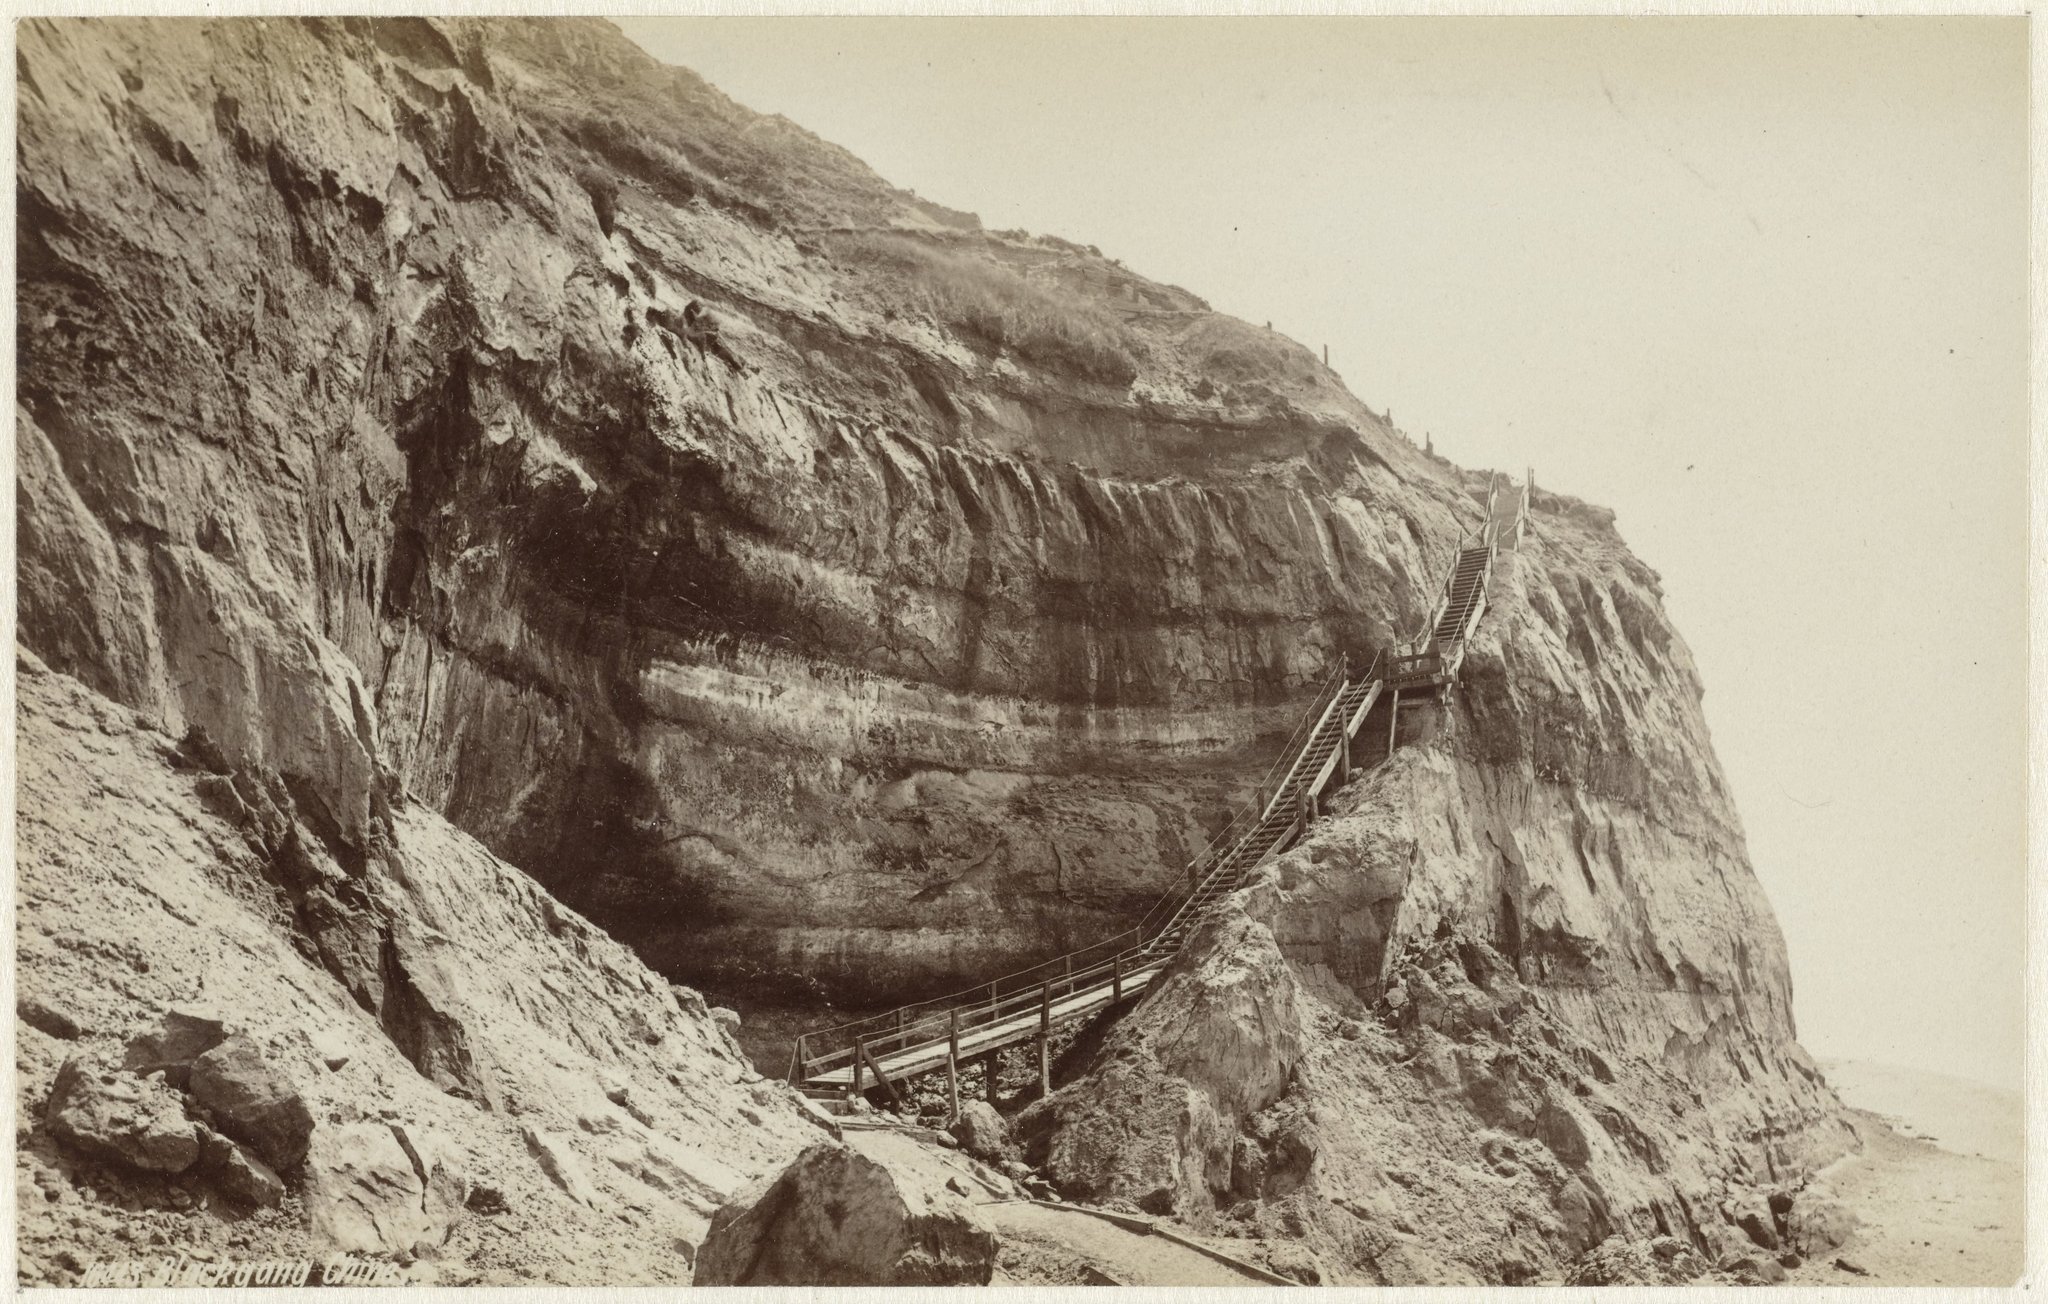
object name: photograph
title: Rotskust met trap bij Blackgang Chine op het Isle of Wight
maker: Anonymous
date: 1851-1900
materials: paper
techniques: albumen print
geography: isle of wight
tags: coastal cliff or crag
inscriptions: address: ‘Knight's Library,/ 147 & 149, High Str., and/ Bank Buildings, Curch Str.,/ VENTNOR I.W.’, number: ‘10443’